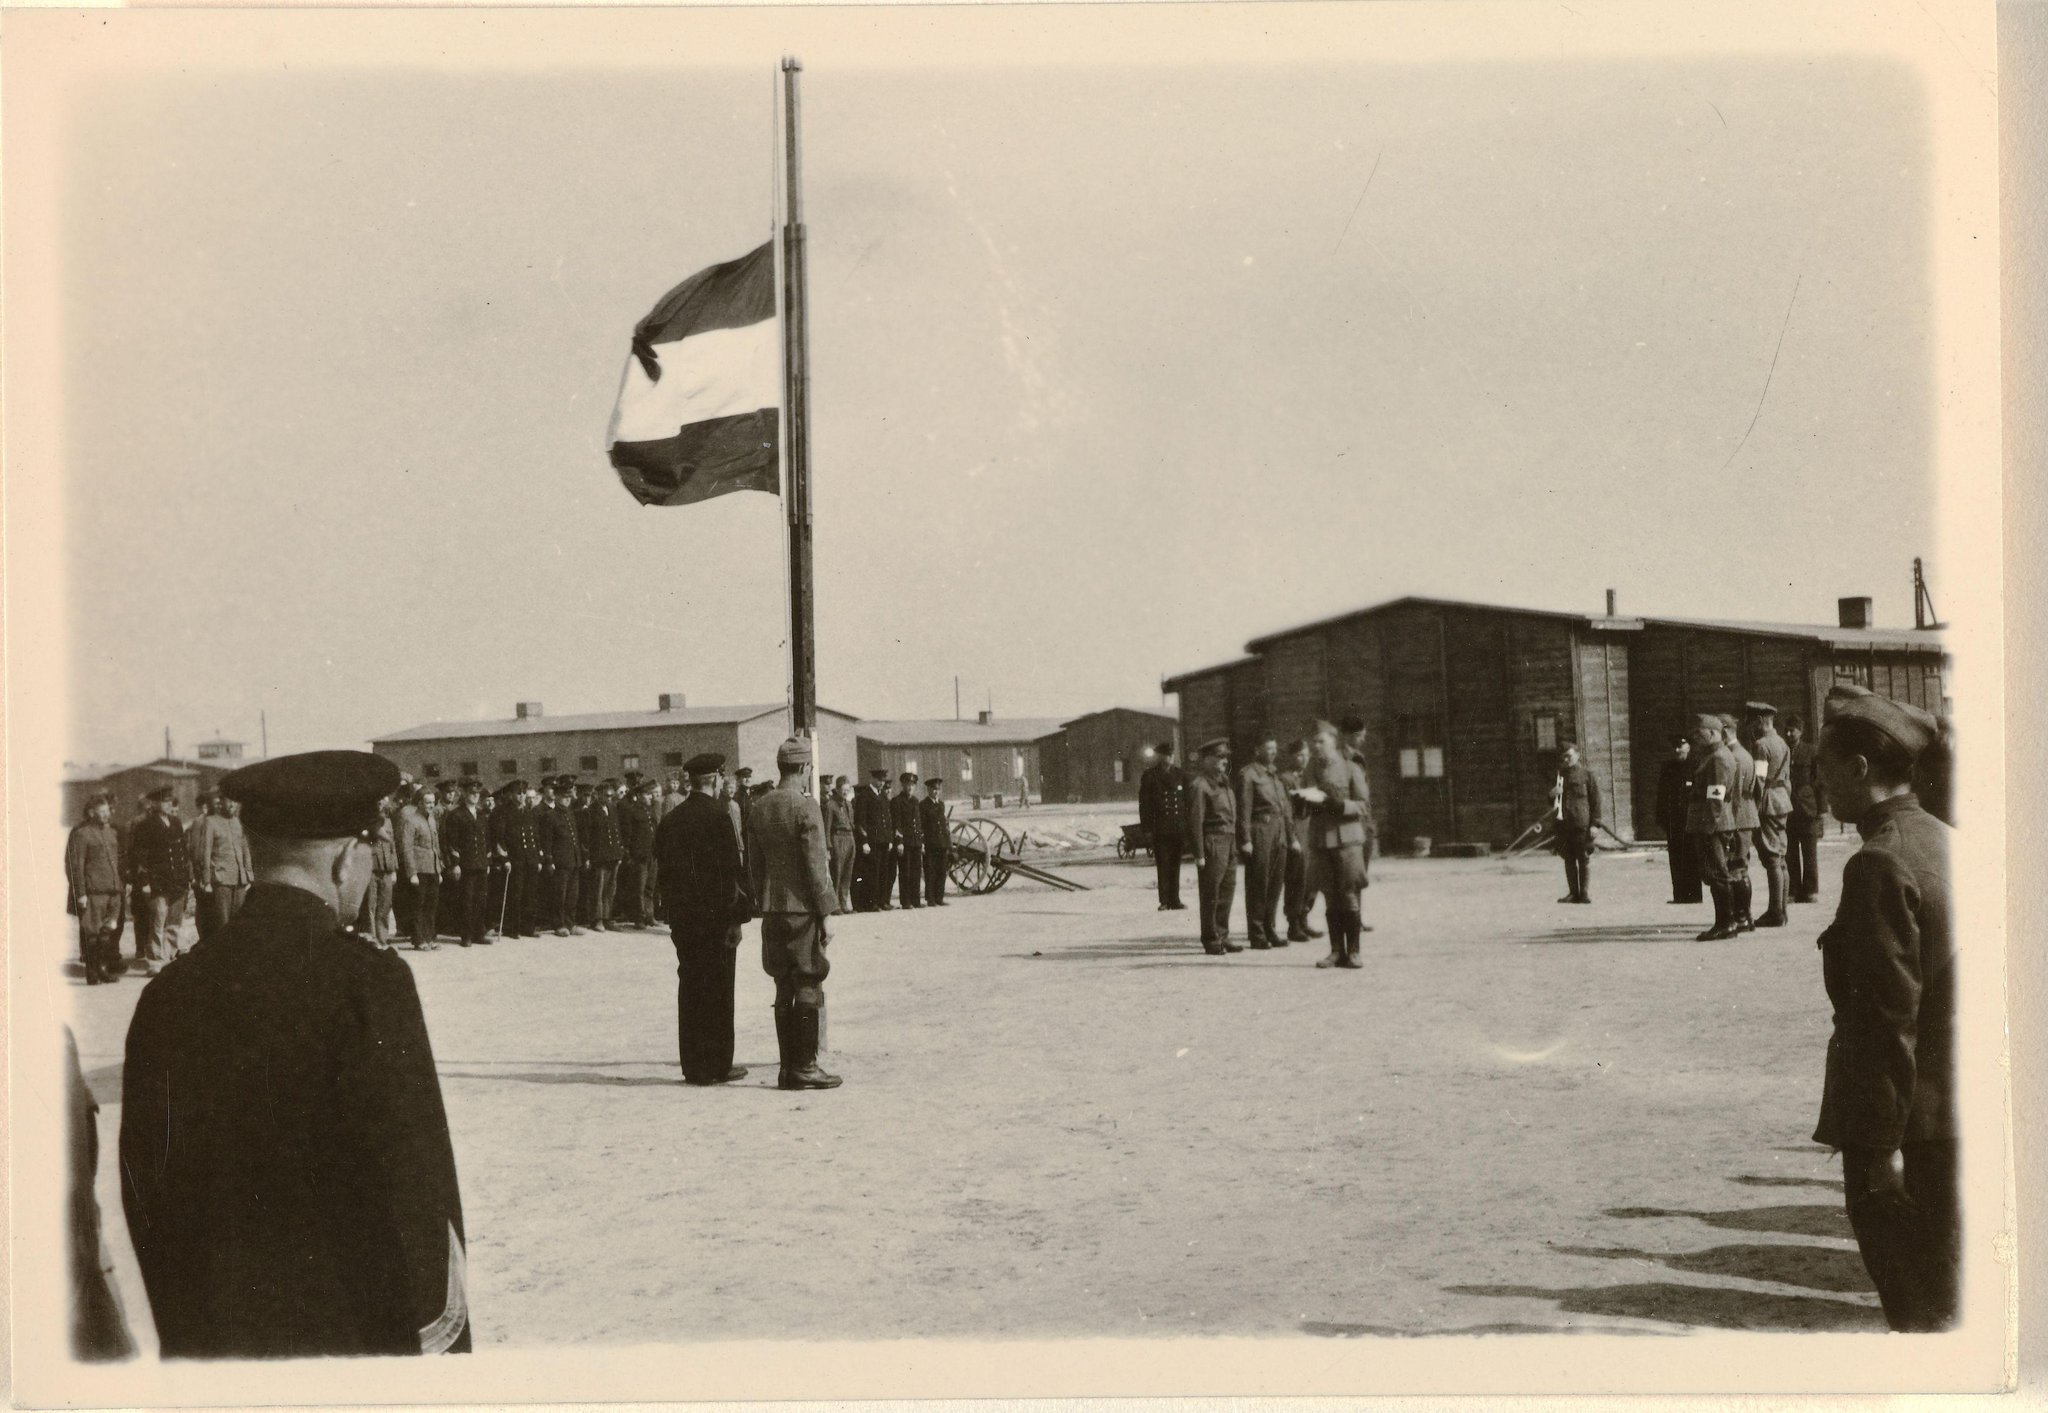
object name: photograph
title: Laatste Nederlandse appel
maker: dick w.b. van maarseveen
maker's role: fotograaf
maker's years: 1905-1990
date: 1945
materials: photographic support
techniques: gelatin silver print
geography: muhlberg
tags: the hague, dick w.b. van maarseveen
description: Het laatste appel van de Nederlanders in het kamp kort na de bevrijding, 1945. De Nederlandse vlag wordt gehesen. Onderdeel van een groep foto's gemaakt door Dick van Maarseveen in het Duitse krijgsgevangenenkamp Stalag IV B in Mühlberg in de periode 1943-1945.